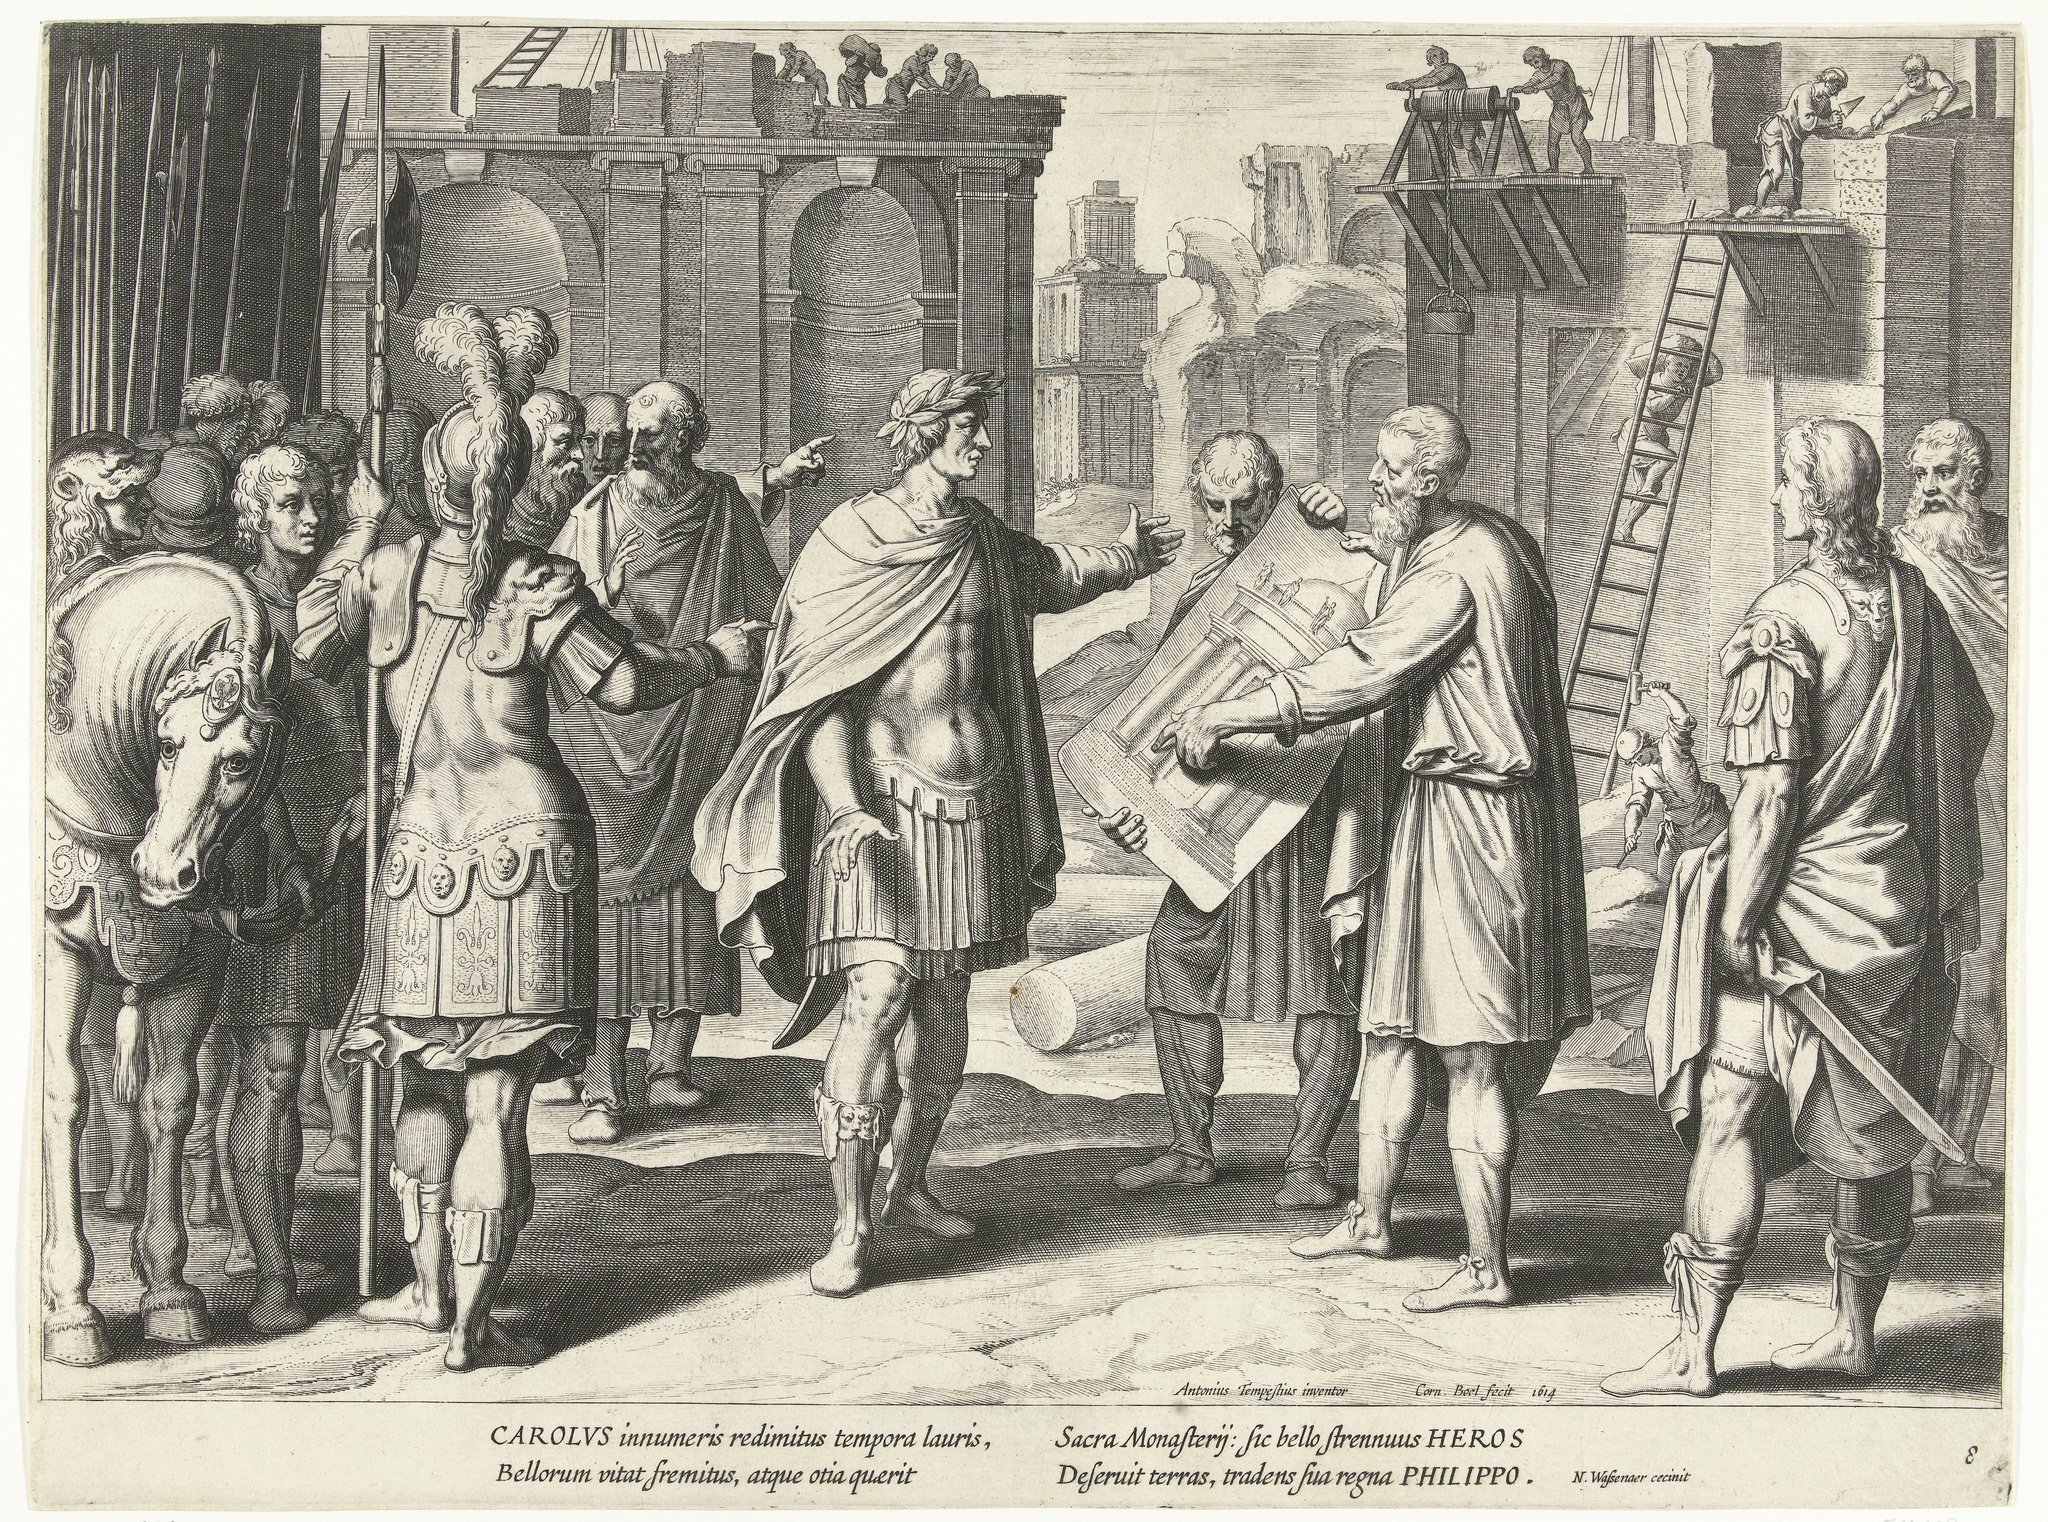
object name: history print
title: Triomfen van Karel V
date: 1614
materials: paper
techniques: engraving, etching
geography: southern netherlands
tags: ghent, charles v (holy roman emperor and king of spain), building of church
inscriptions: collector's mark: Lugt 2228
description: Keizer Karel V in overleg met de architecten van het klooster dat hij laat bouwen om hier van zijn regeringsperiode uit te kunnen rusten. Op de achtergrond bouwwerkzaamheden. Met onderschrift van vier regels in het Latijn. Deze prent is onderdeel van een reeks van acht prenten, elk een triomf van Karel V voorstellende.